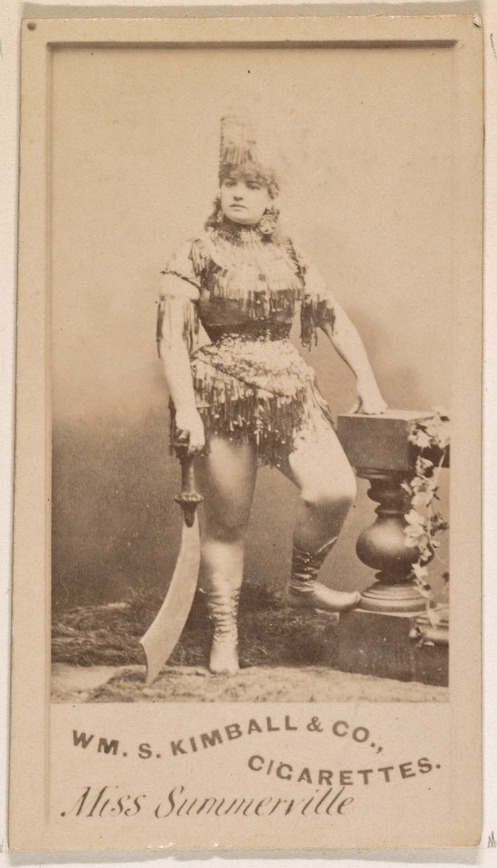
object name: photograph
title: Miss Summerville, from the Actresses series (N203) issued by Wm. S. Kimball & Co.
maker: william s. kimball & company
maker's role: publisher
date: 1889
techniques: color lithograph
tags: portraits,women,actresses